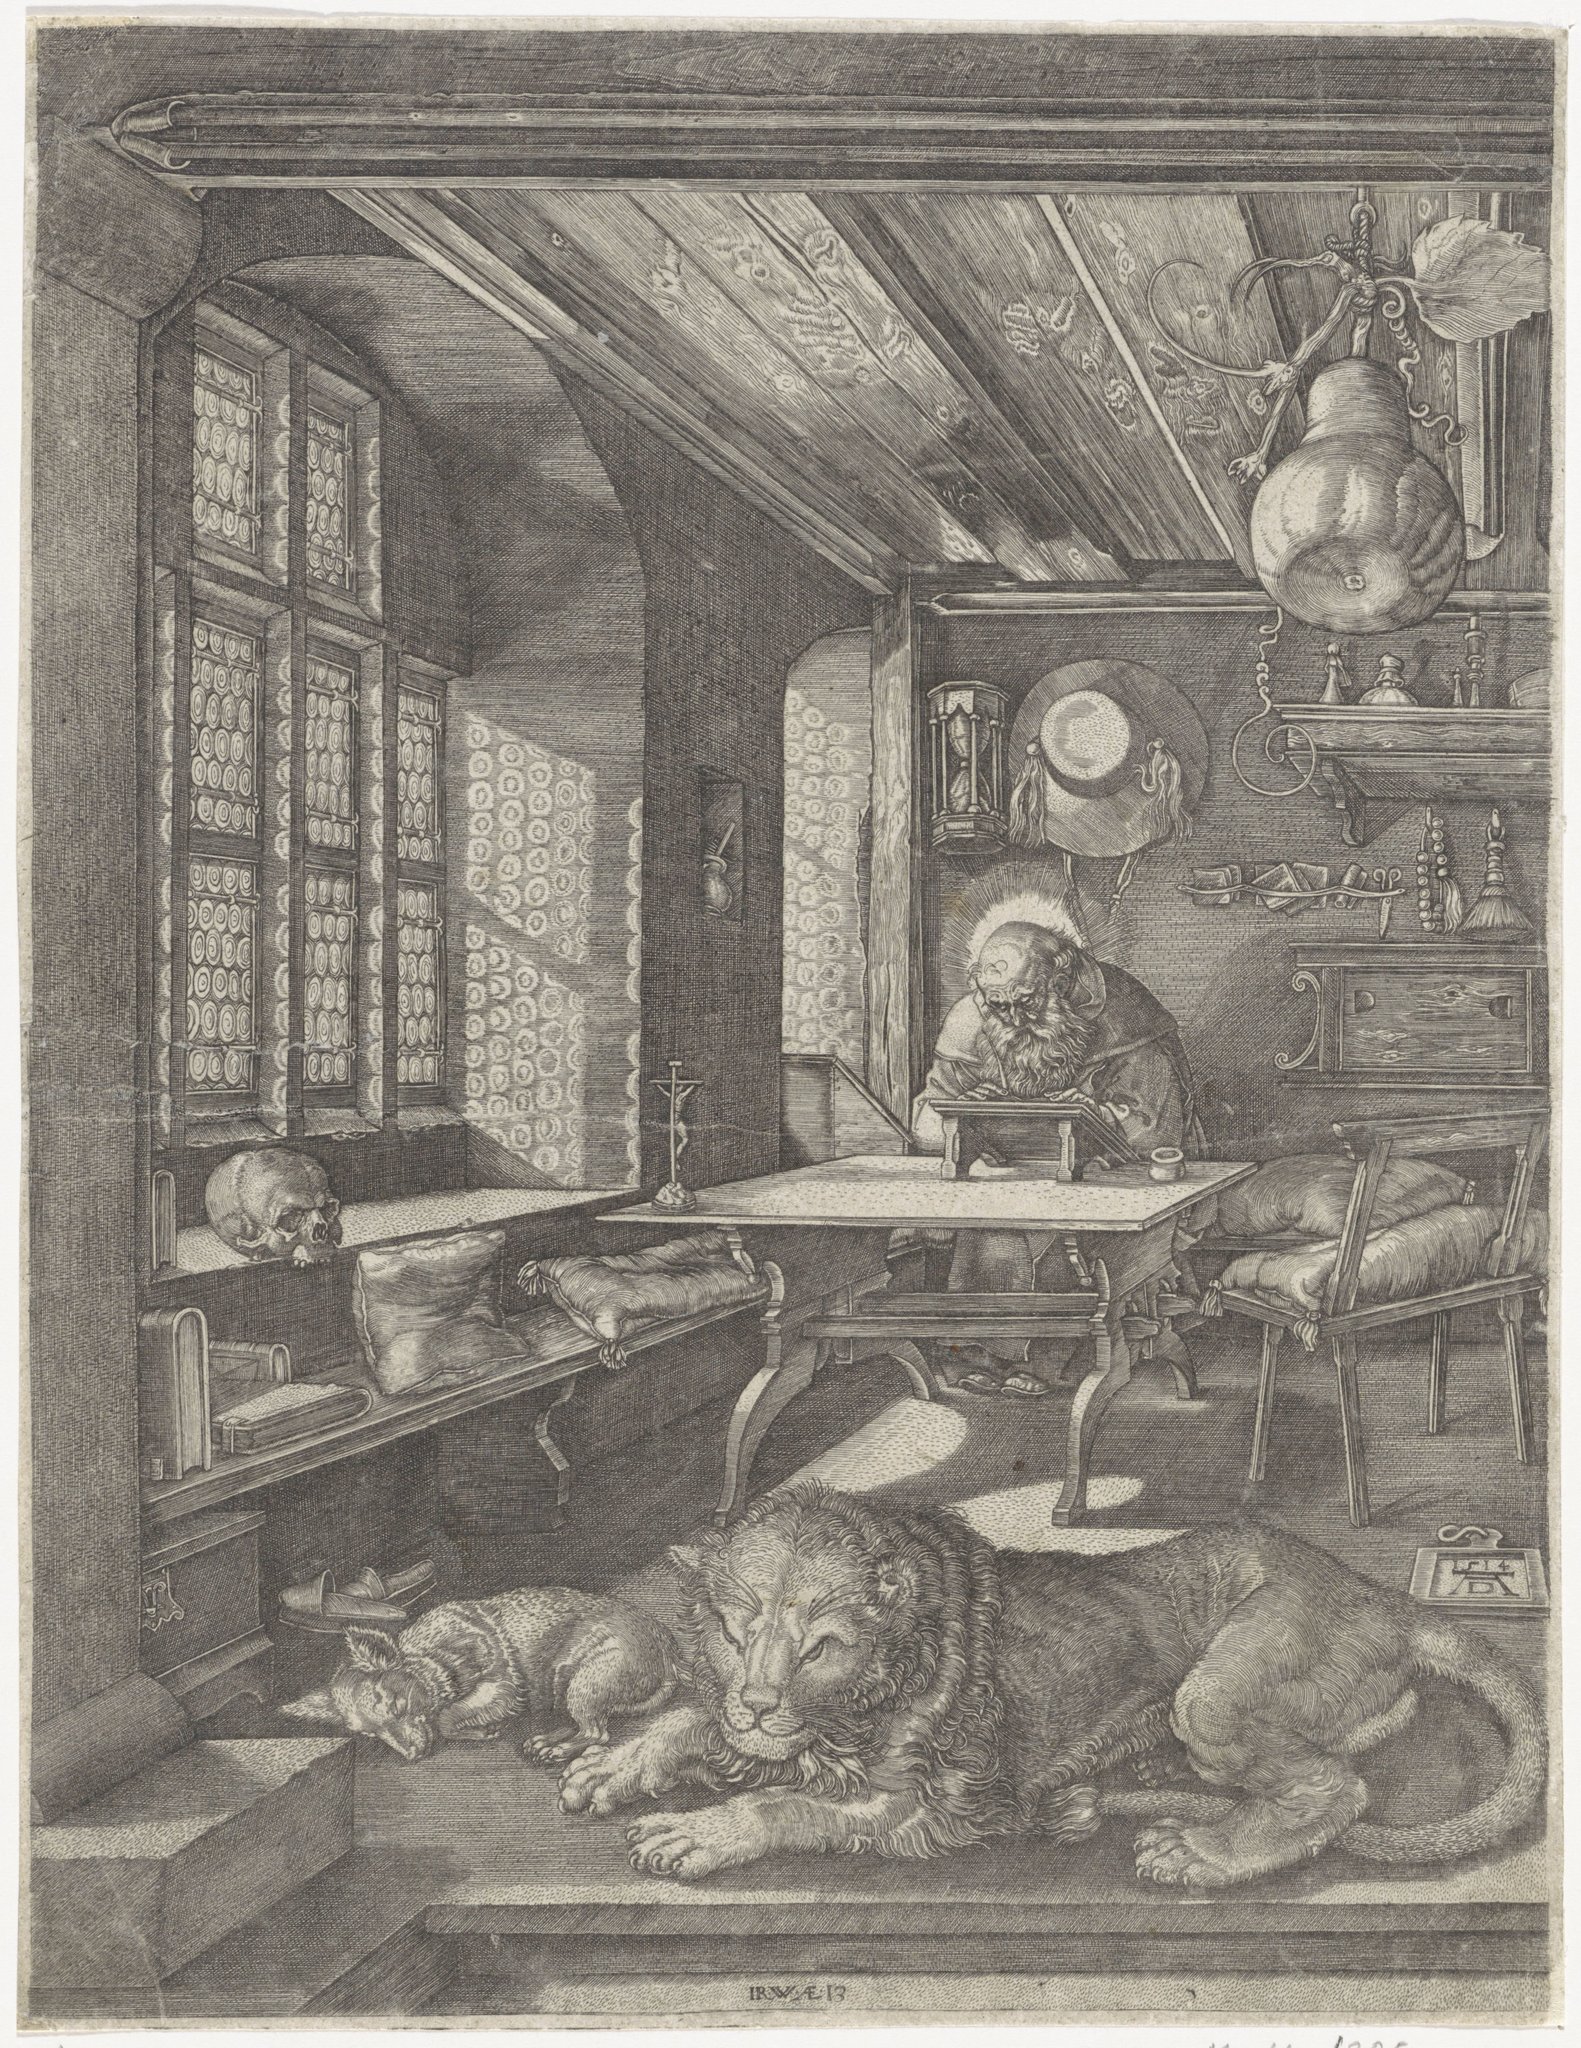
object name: print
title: Kerkvader Hieronymus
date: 1564-1568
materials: paper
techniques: engraving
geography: antwerp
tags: st. jerome as doctor of the latin church in his study with book, pen and ink; lion and cardinal's hat beside him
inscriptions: collector's mark: Lugt 2165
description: De heilige Hiëronymus zit in een studeervertrek te lezen aan een tafel bij een raam. Aan de muur achter hem hangen een zandloper en zijn kardinaalshoed. Op de voorgrond liggen een leeuw en een hond. Rechts op een tablet het monogram van Albrecht Dürer en de datering van diens prent.